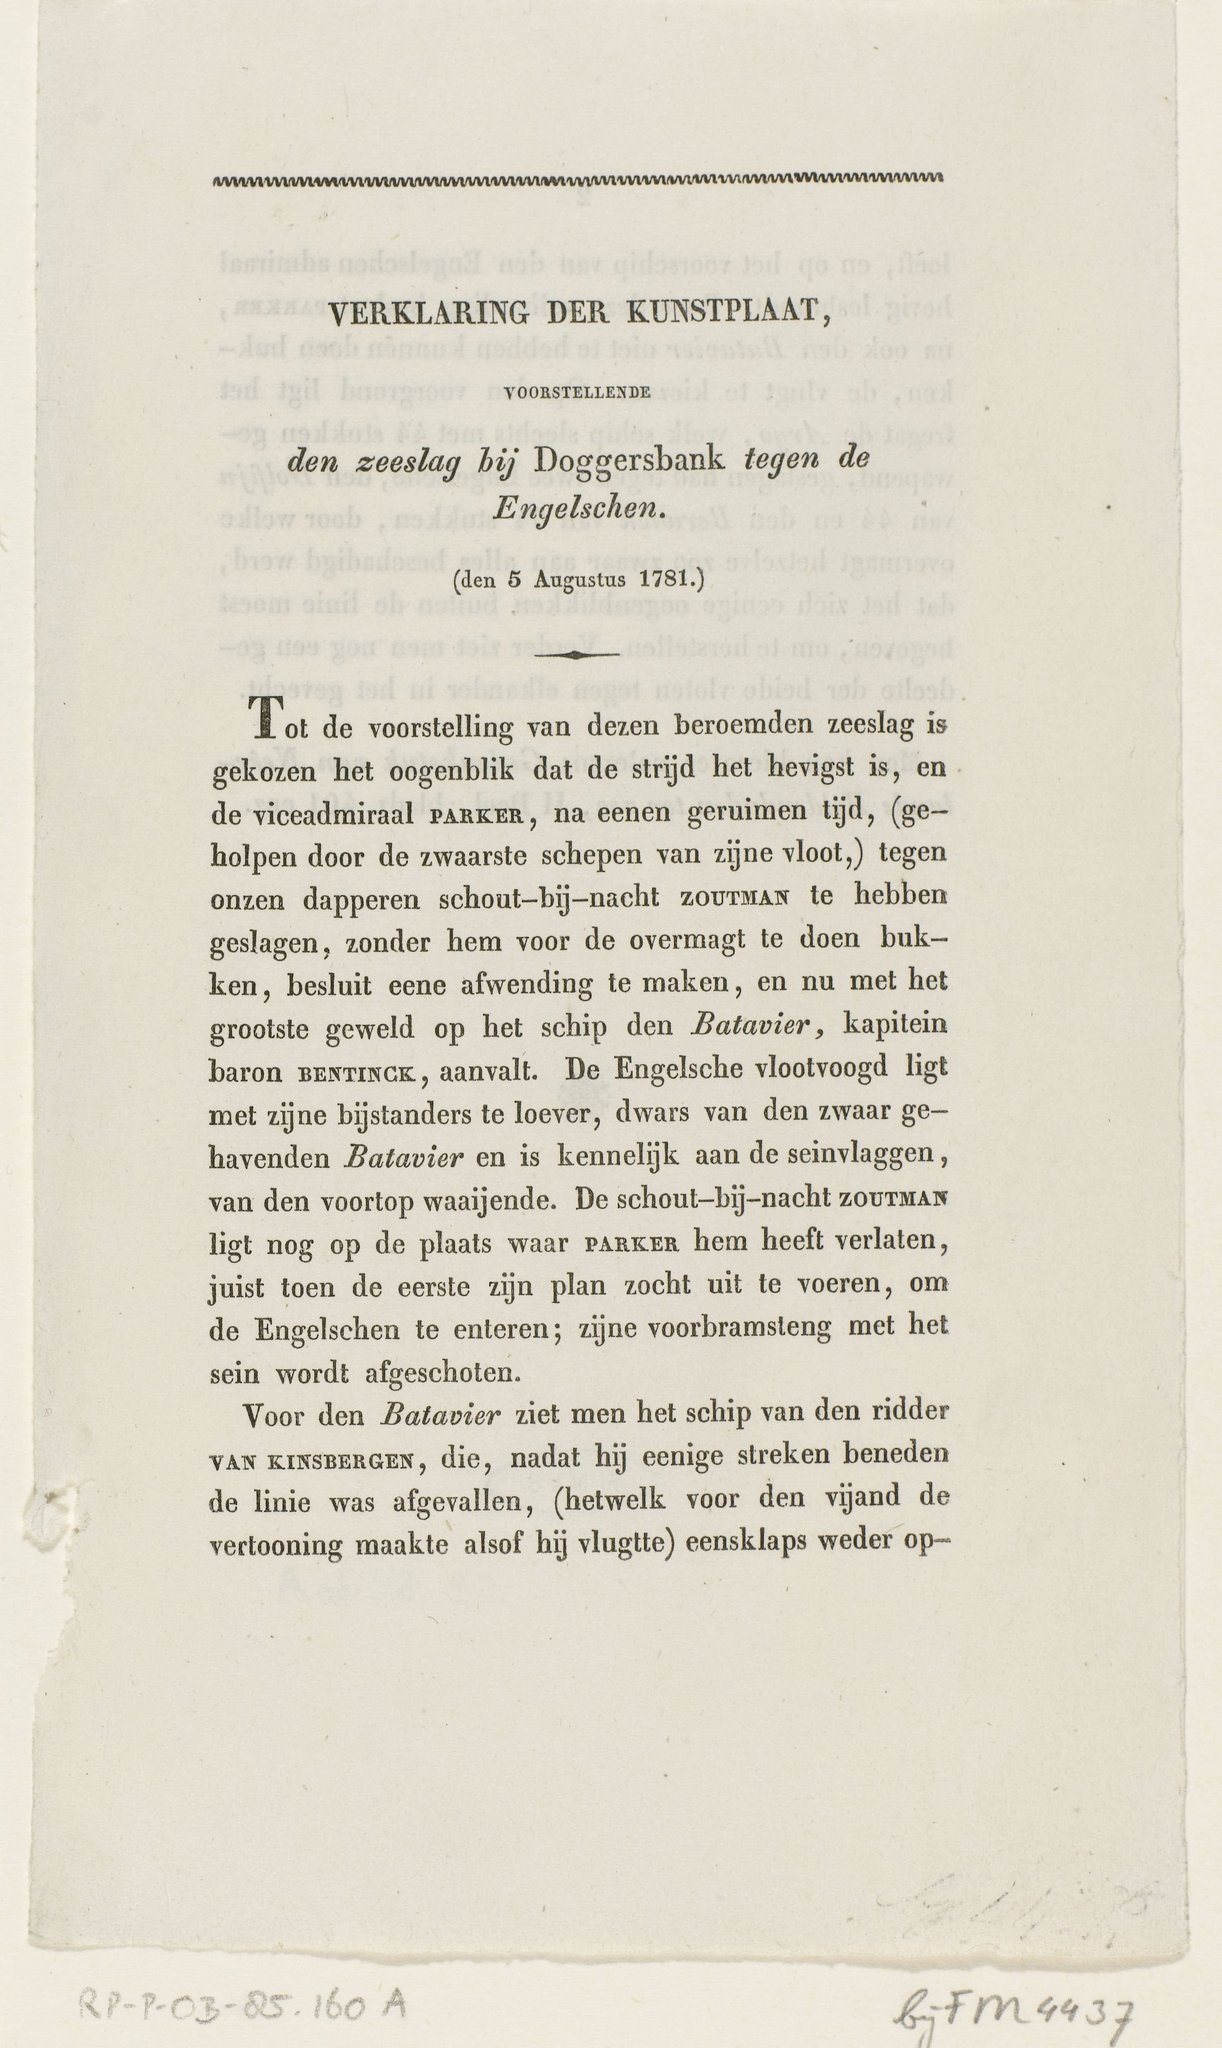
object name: text sheet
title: Tekstblad bij de prent van de Zeeslag bij Doggersbank, 1781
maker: Anonymous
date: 1828-1834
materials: paper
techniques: letterpress printing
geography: netherlands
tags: the hague, johan arnold zoutman, hyde parker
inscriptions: collector's mark: Lugt 2228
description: Tekstblad met een uitleg van de voorstelling van de Zeeslag bij Doggersbank op 5 augustus 1781 tussen de Nederlandse vloot onder schout-bij-nacht Johan Zoutman en de Engelse vloot onder vice-admiraal Hyde Parker. Bladzijde bedrukt op beide zijden.